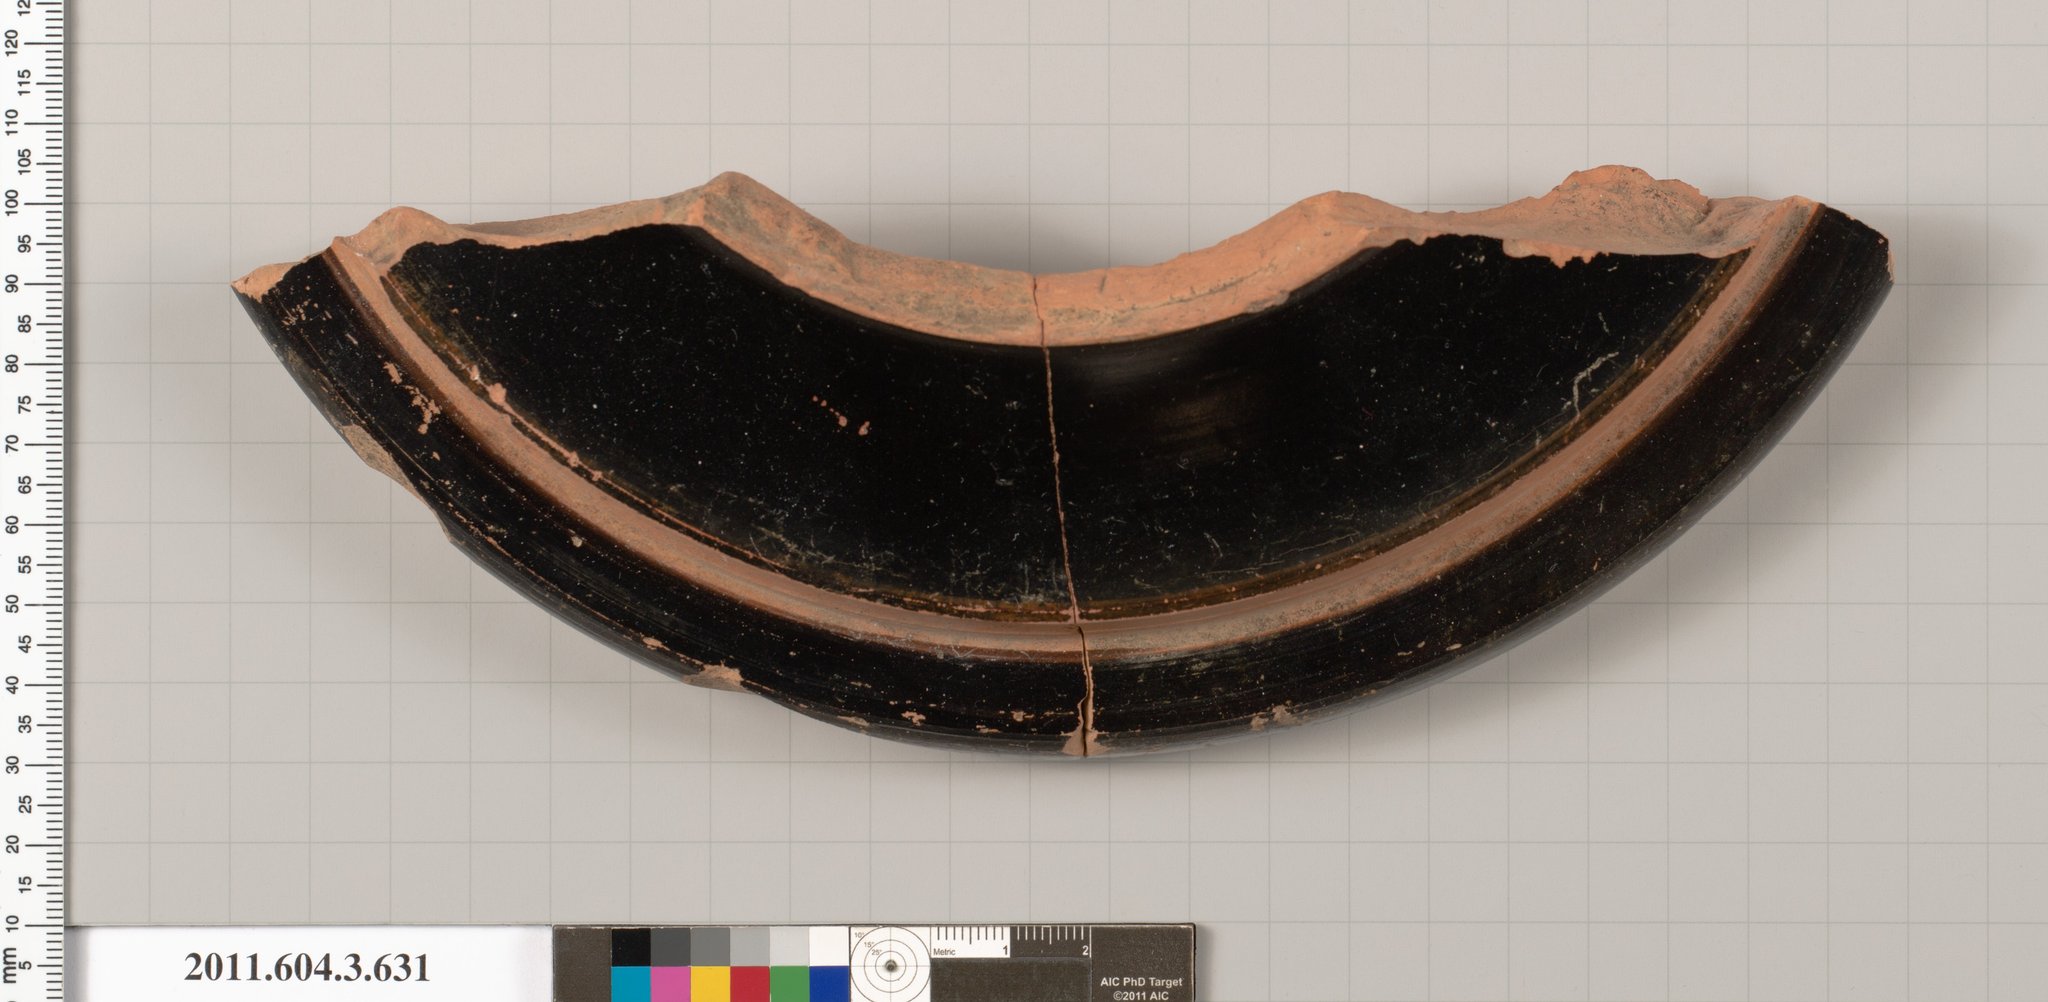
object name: calyx krater fragment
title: Terracotta fragment of a calyx-krater (bowl for mixing wine and water)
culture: greek, attic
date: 600-401 BCE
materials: terracotta